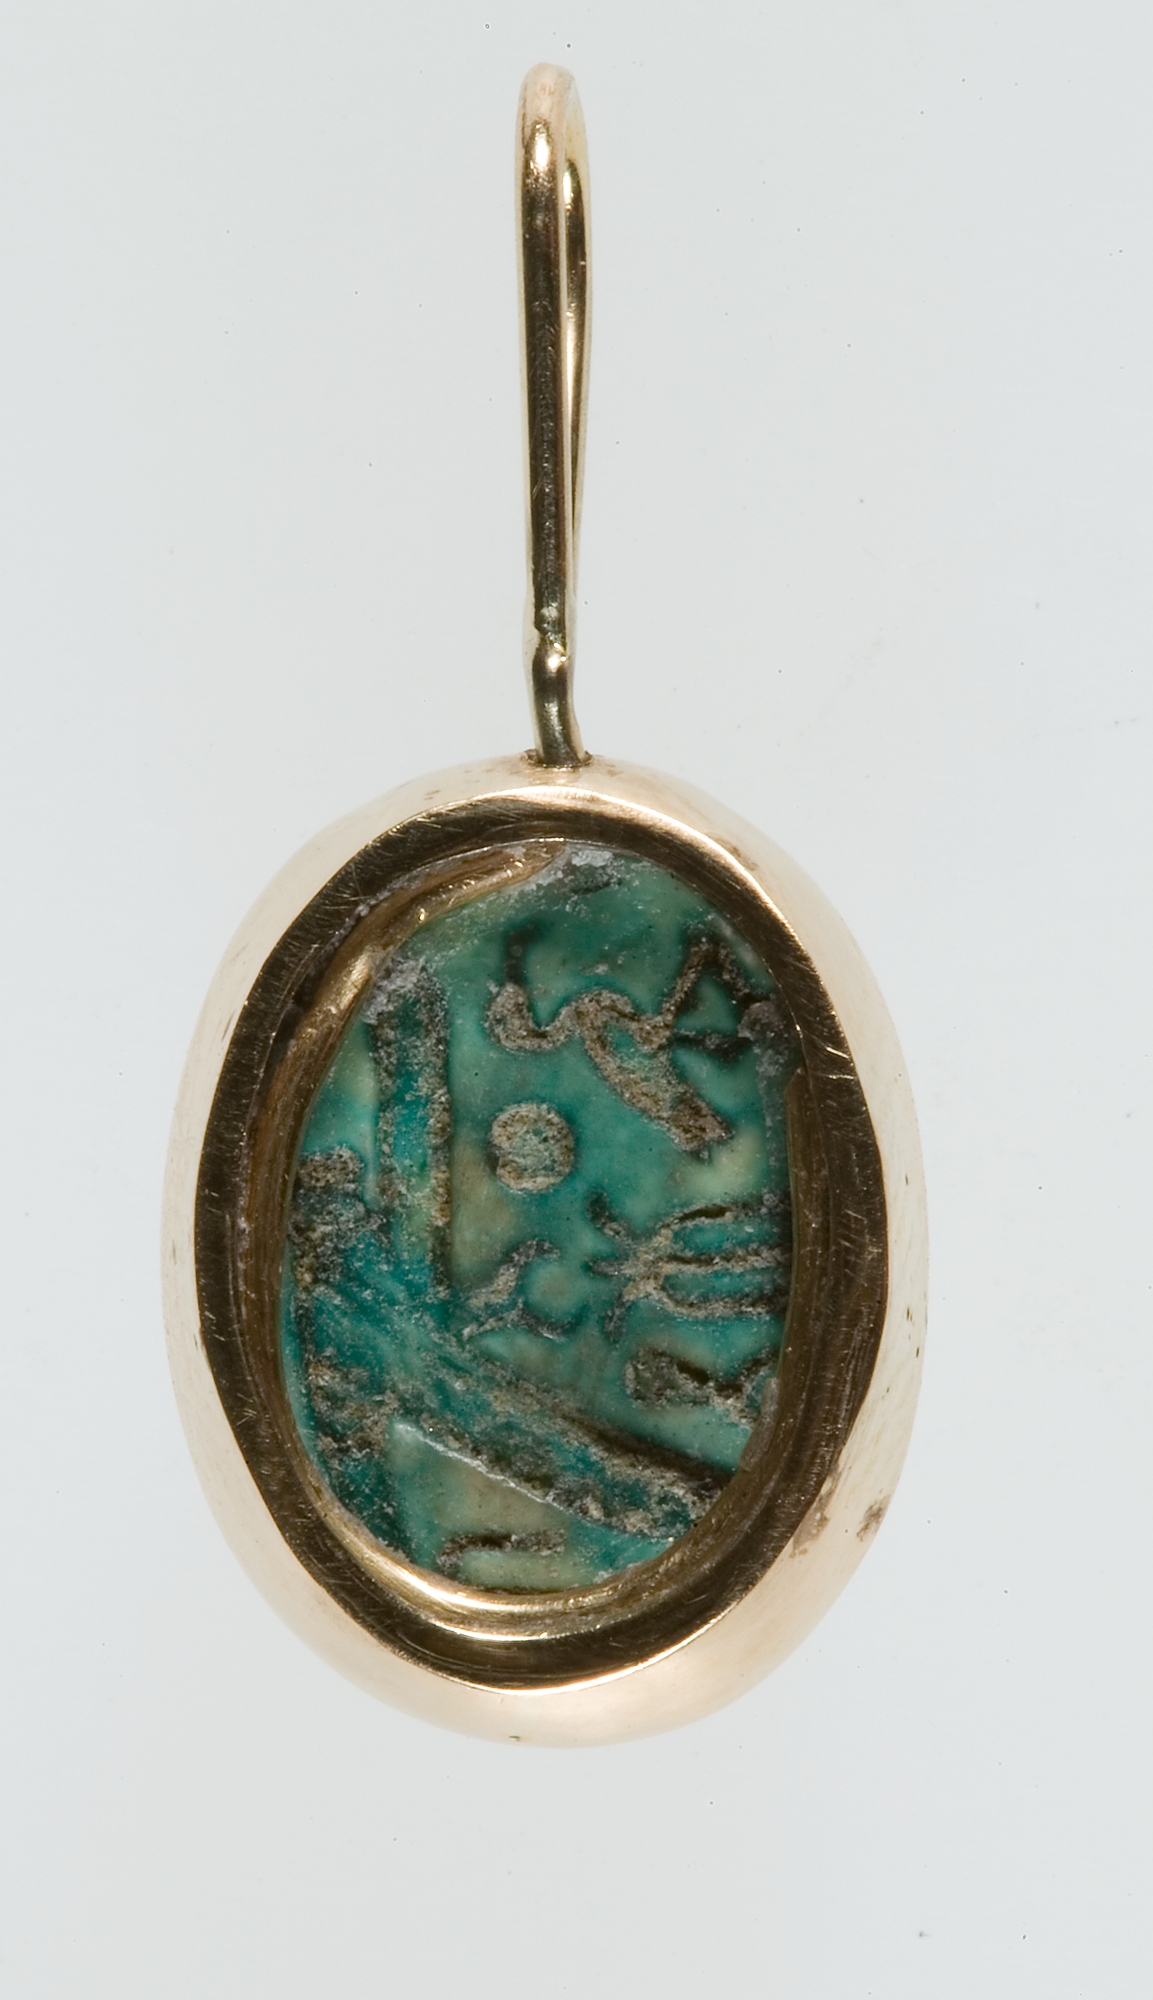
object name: scarab in modern pendant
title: A modern pendant setting holding an inscribed scarab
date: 1479-1425 BCE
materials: gold, stone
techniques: glazing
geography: egypt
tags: hieroglyphs,scarabs